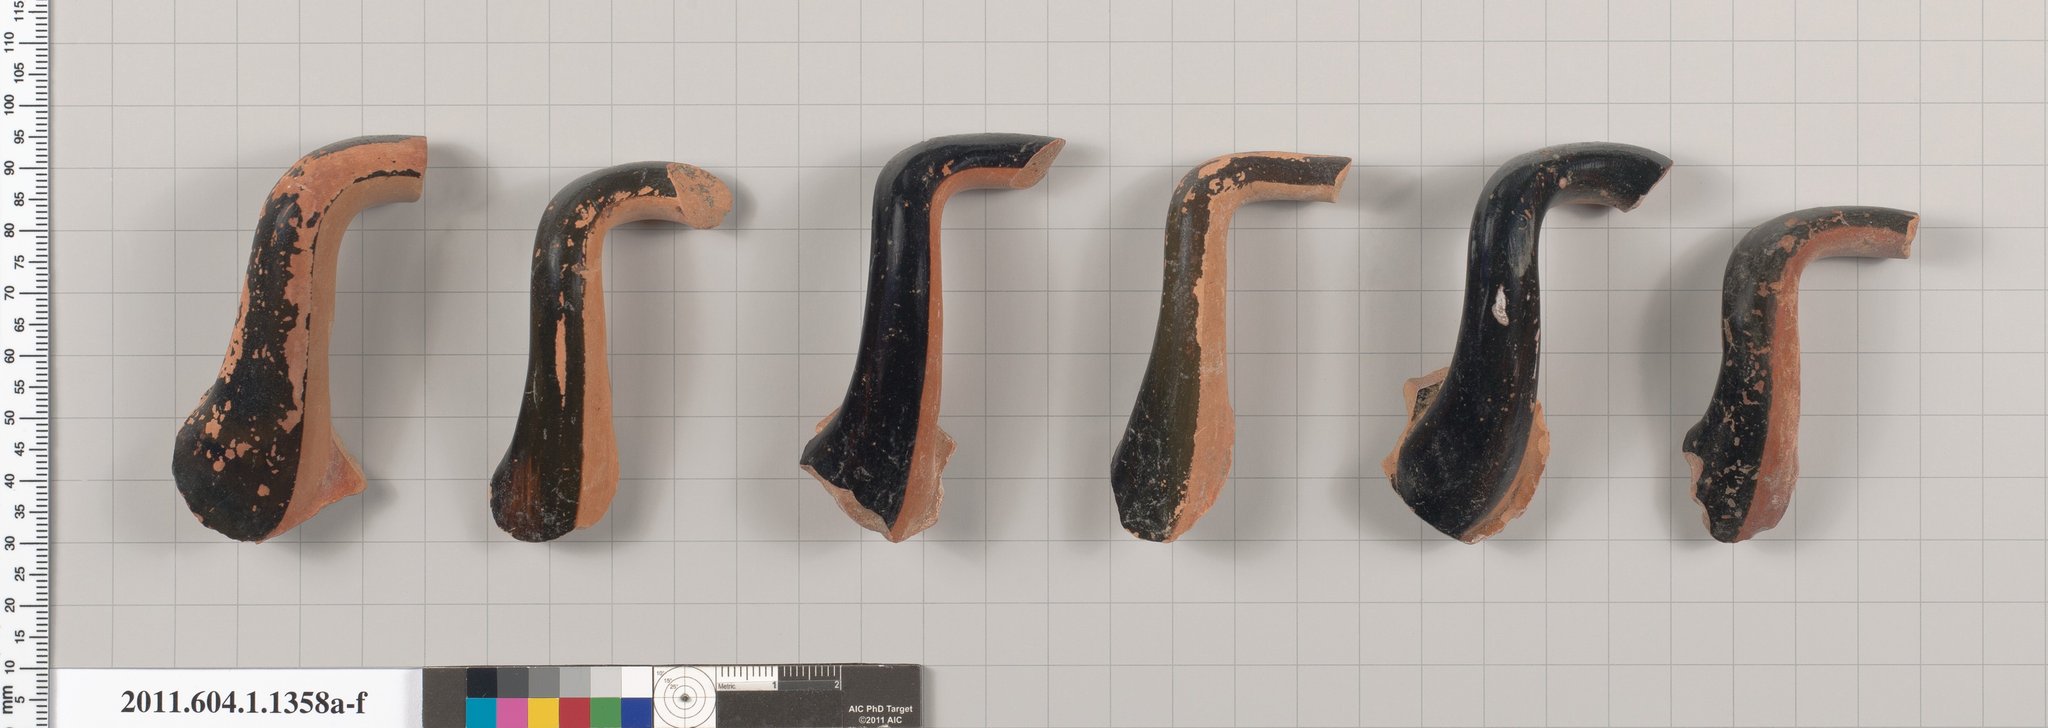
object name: kylix fragment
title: Terracotta fragments of kylikes (drinking cups)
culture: greek, attic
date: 500-401 BCE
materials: terracotta